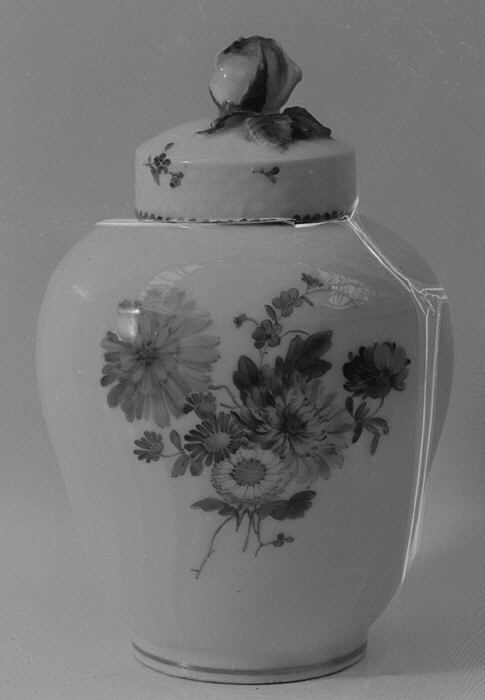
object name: tea caddy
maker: royal porcelain manufactory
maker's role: factory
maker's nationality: danish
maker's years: 1775-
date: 1801-1900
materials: hard paste porcelain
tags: flowers